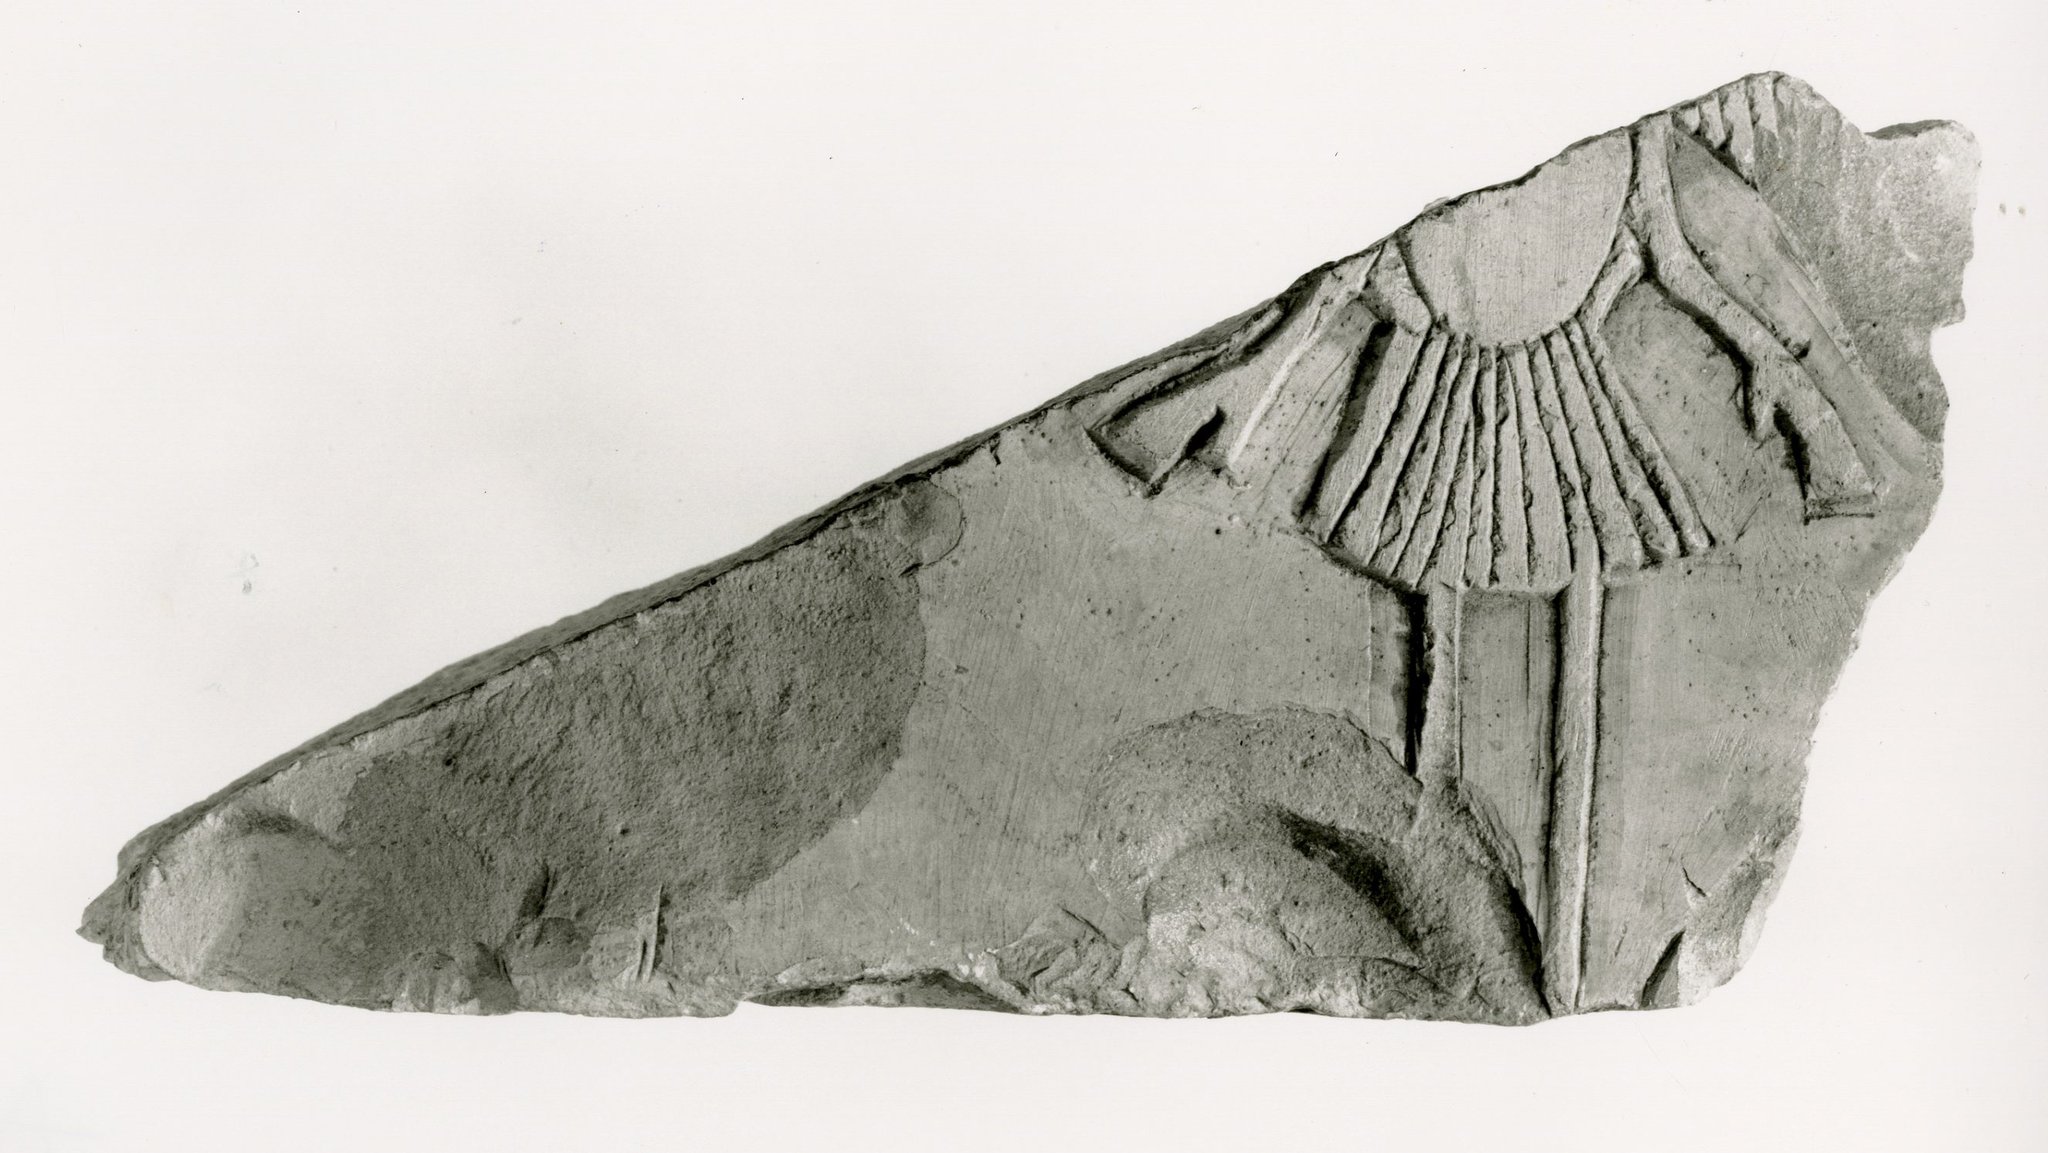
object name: relief, tomb of nespekashuty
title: Raised relief fragment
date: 664-610 BCE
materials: limestone, varnish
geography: egypt